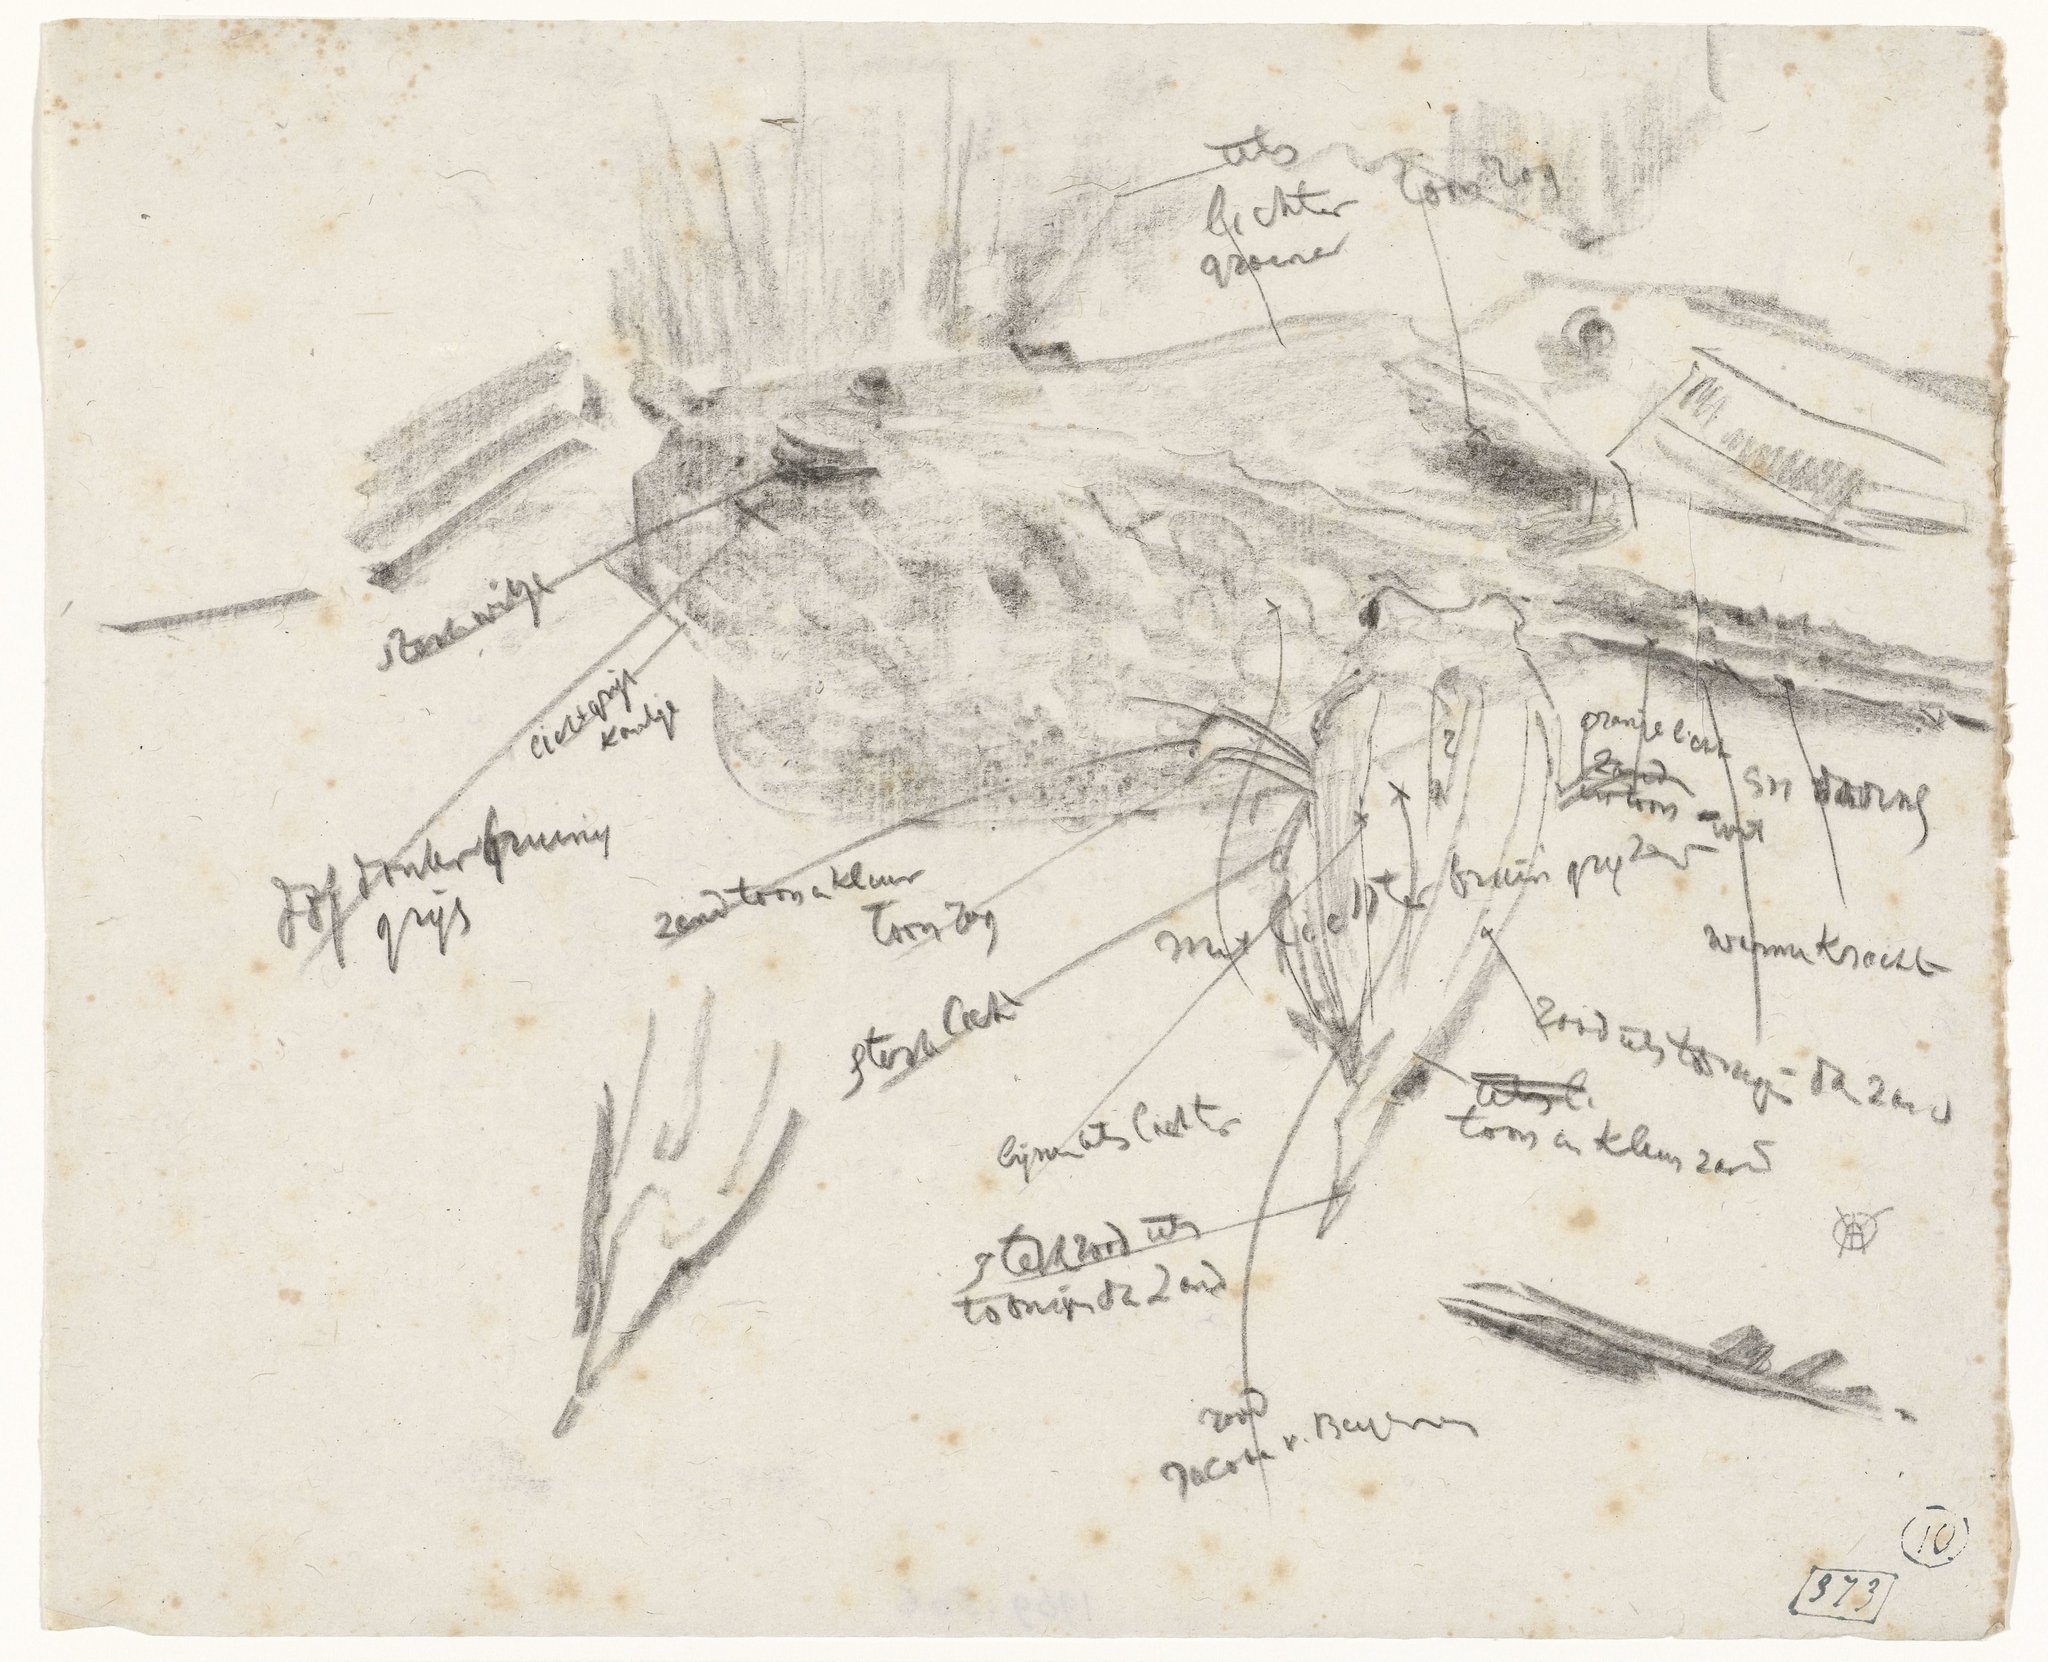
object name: drawing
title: Ponen in een aquarium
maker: gerrit willem dijsselhof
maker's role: designer, draughtsman, print maker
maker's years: 1866-1924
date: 1876-1924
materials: chalk, paper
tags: aquarium, bony fishes: gurnard